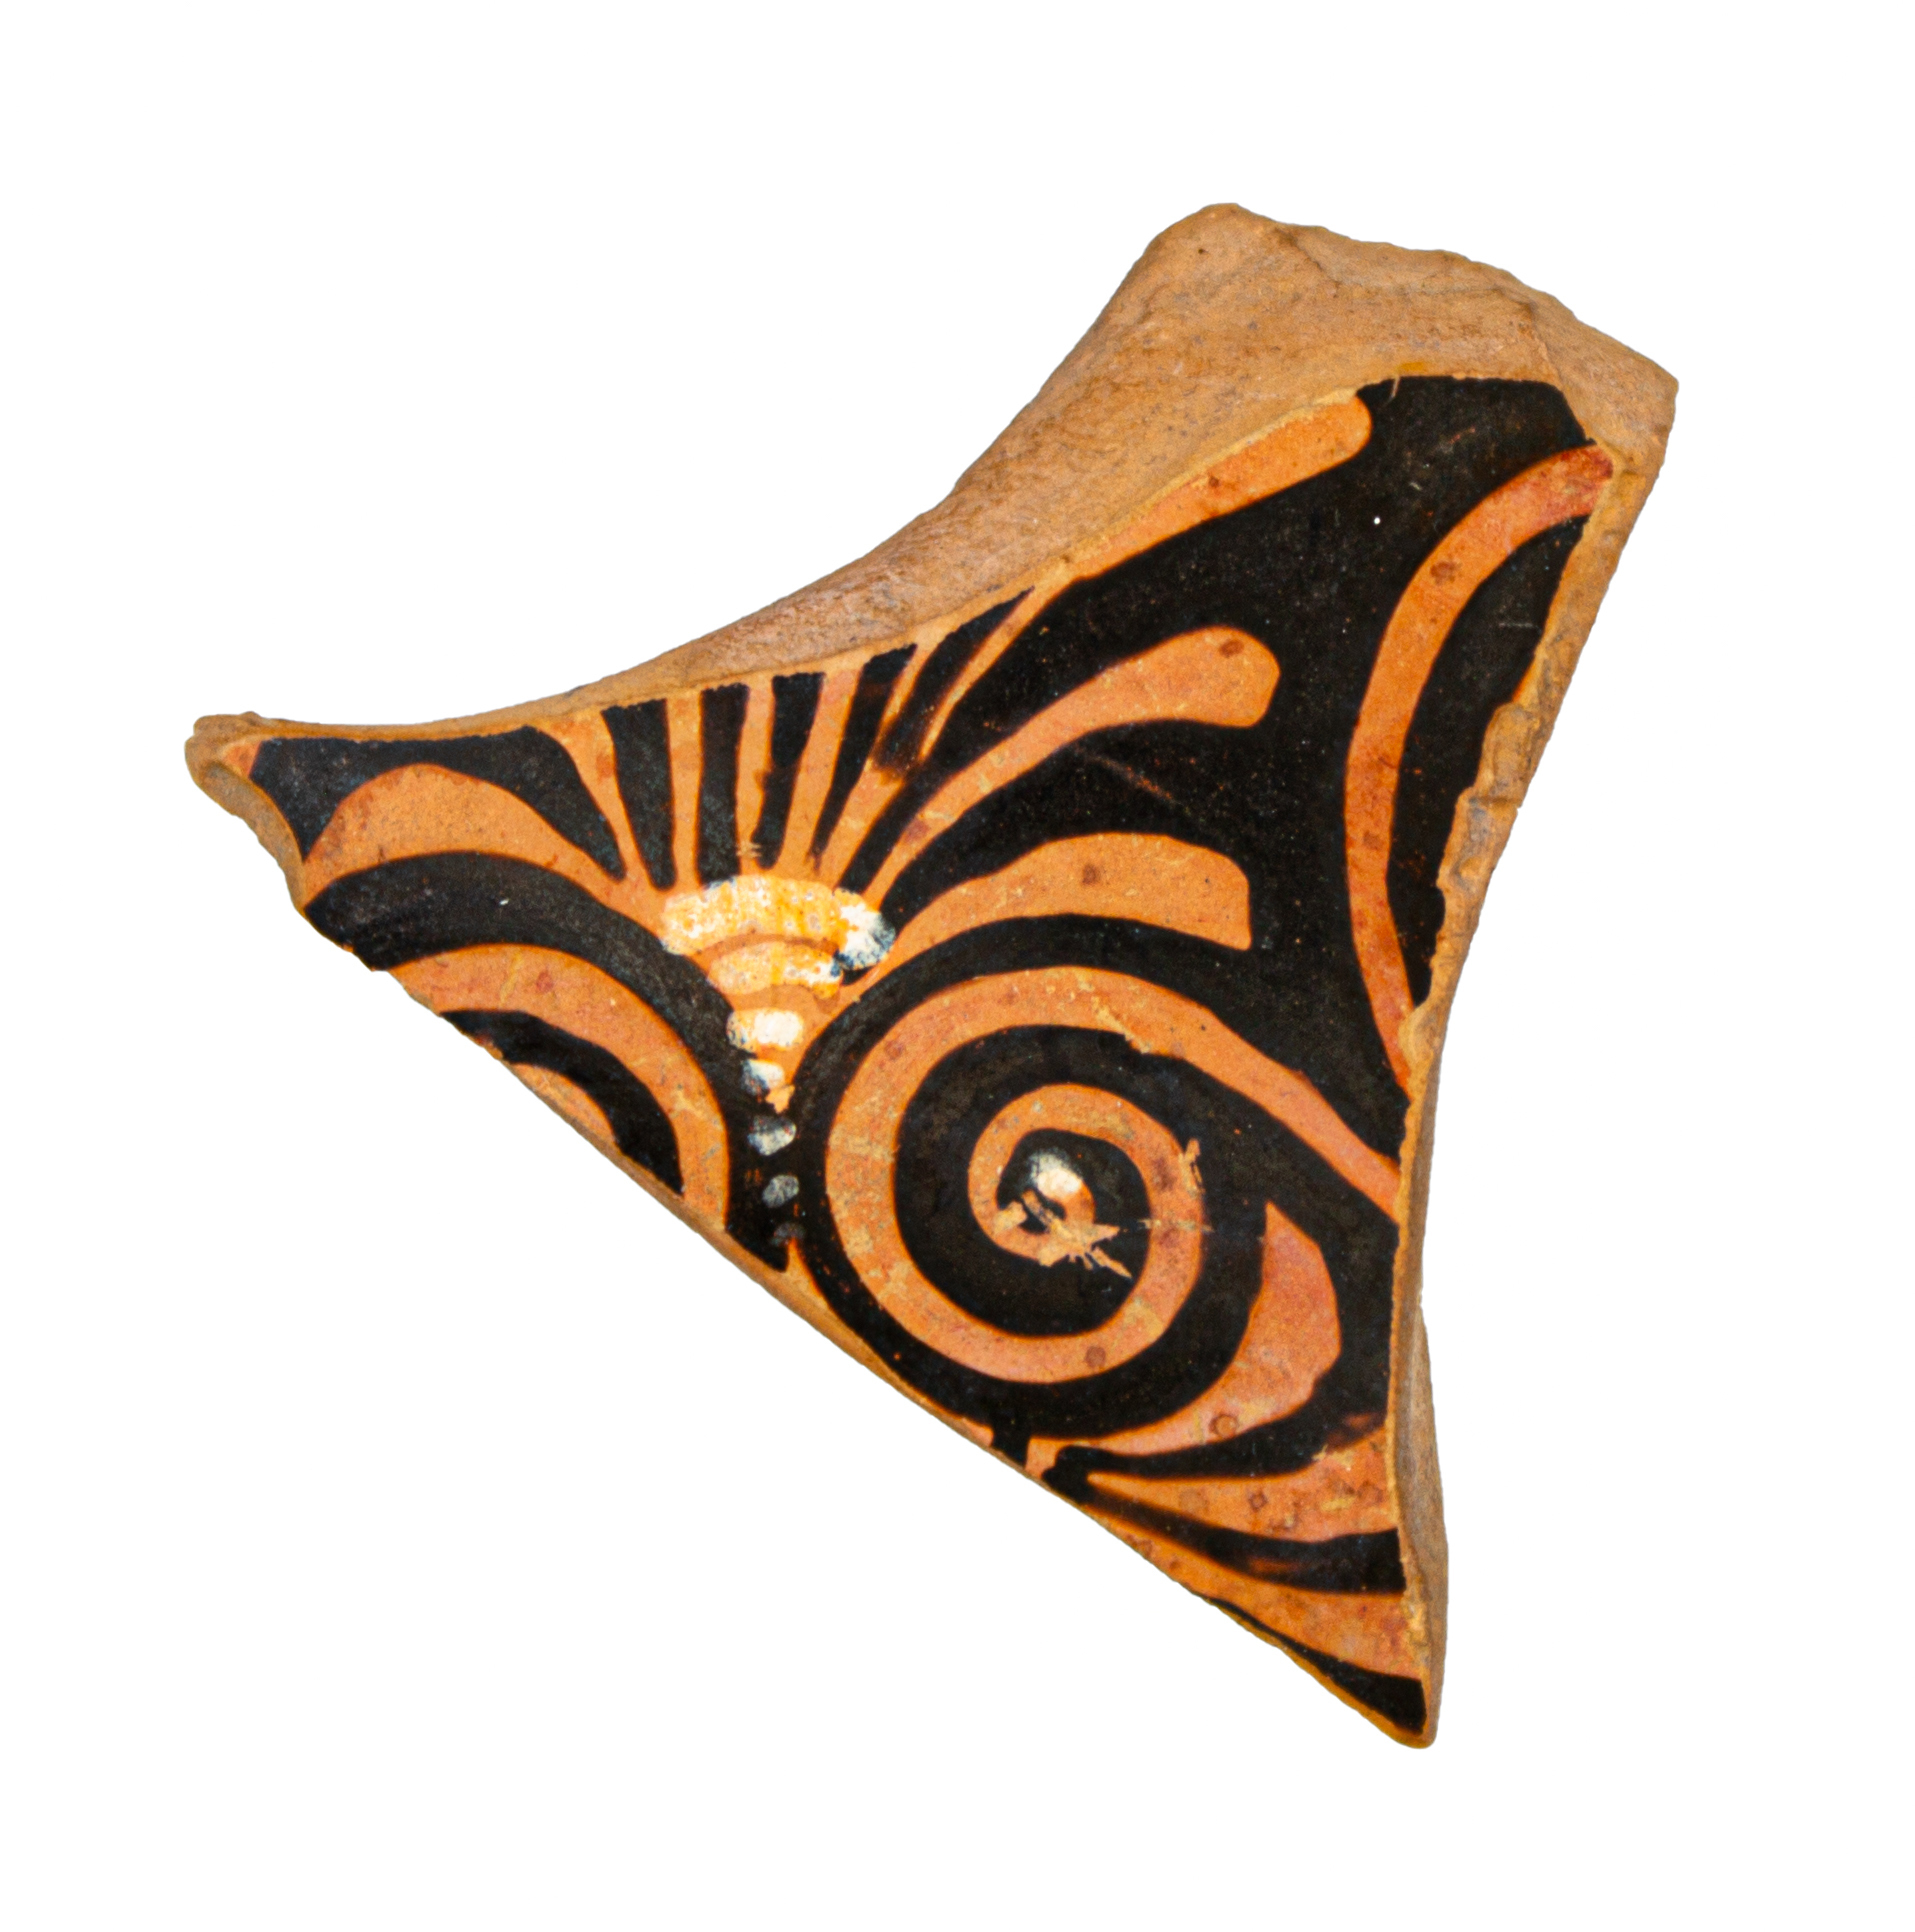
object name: volute krater fragment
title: Volute-krater fragment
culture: greek, south italian, apulian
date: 360-340 BCE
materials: terracotta